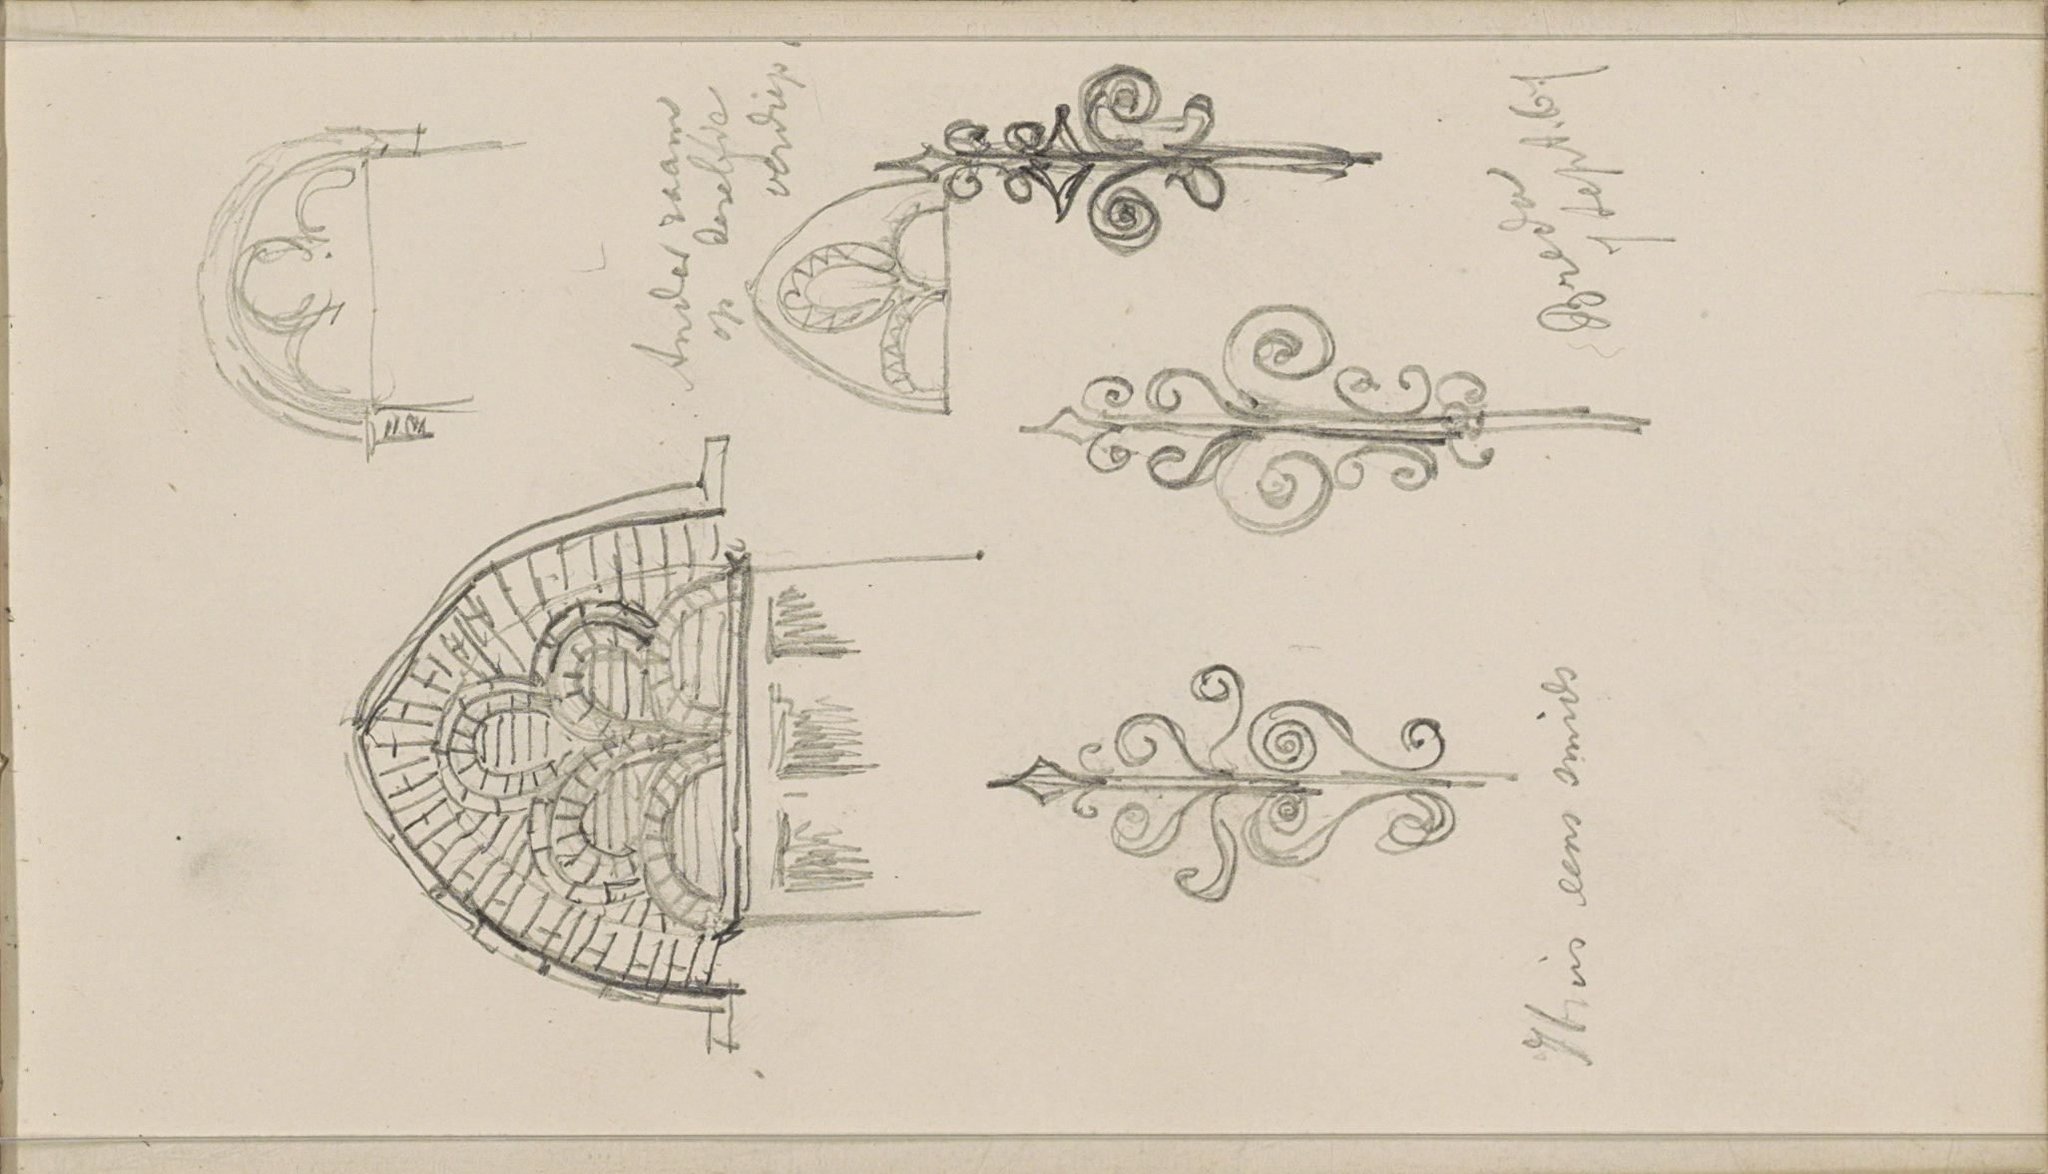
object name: sketchbook leaf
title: Detail van een gevel met boog en een venster te Breda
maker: isaac gosschalk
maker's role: draughtsman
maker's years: 1838-1907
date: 1809-1867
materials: paper, pencil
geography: breda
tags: architectural detail, exterior ~ representation of a building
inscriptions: date and inscription: ‘Ander raam/ op dezelfde/ verdiep./ Huis eens smids/ Breda/ 7 sept. 67’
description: Tevens studies van ornamenten. Blad 47 recto uit een schetsboek met 67 bladen.